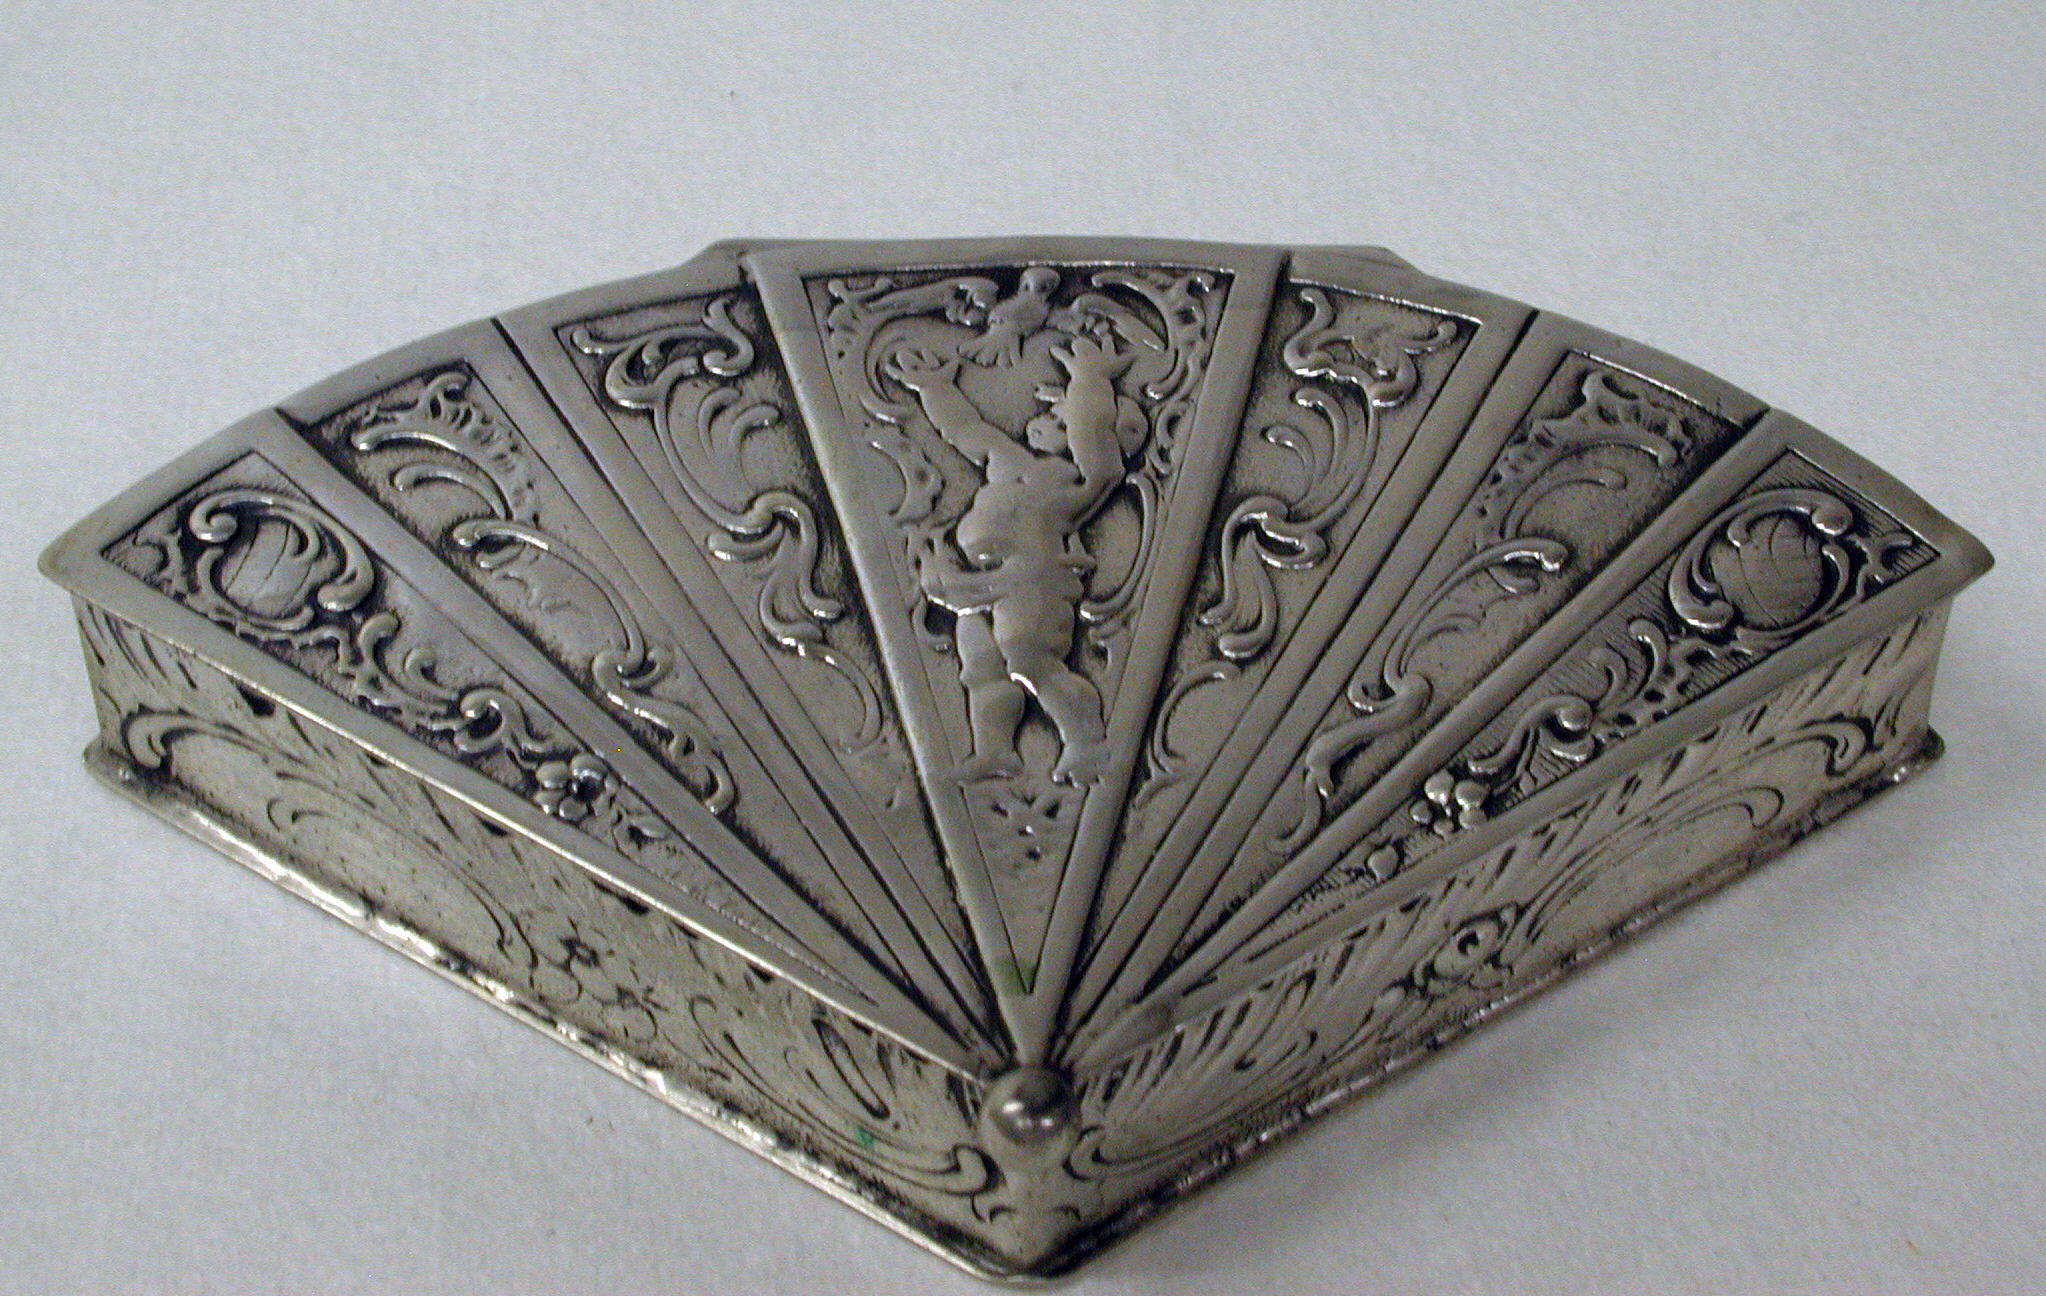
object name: box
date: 1867-1900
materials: silver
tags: doves,fans,putti